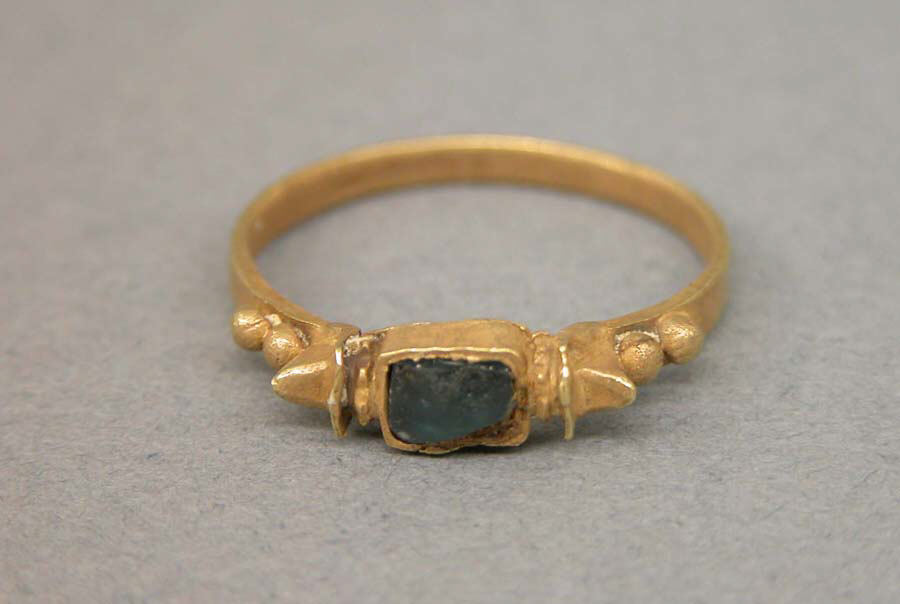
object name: ring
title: Ring with Blue Stone set into Square Bezel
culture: indonesian, javanese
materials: gold, stone